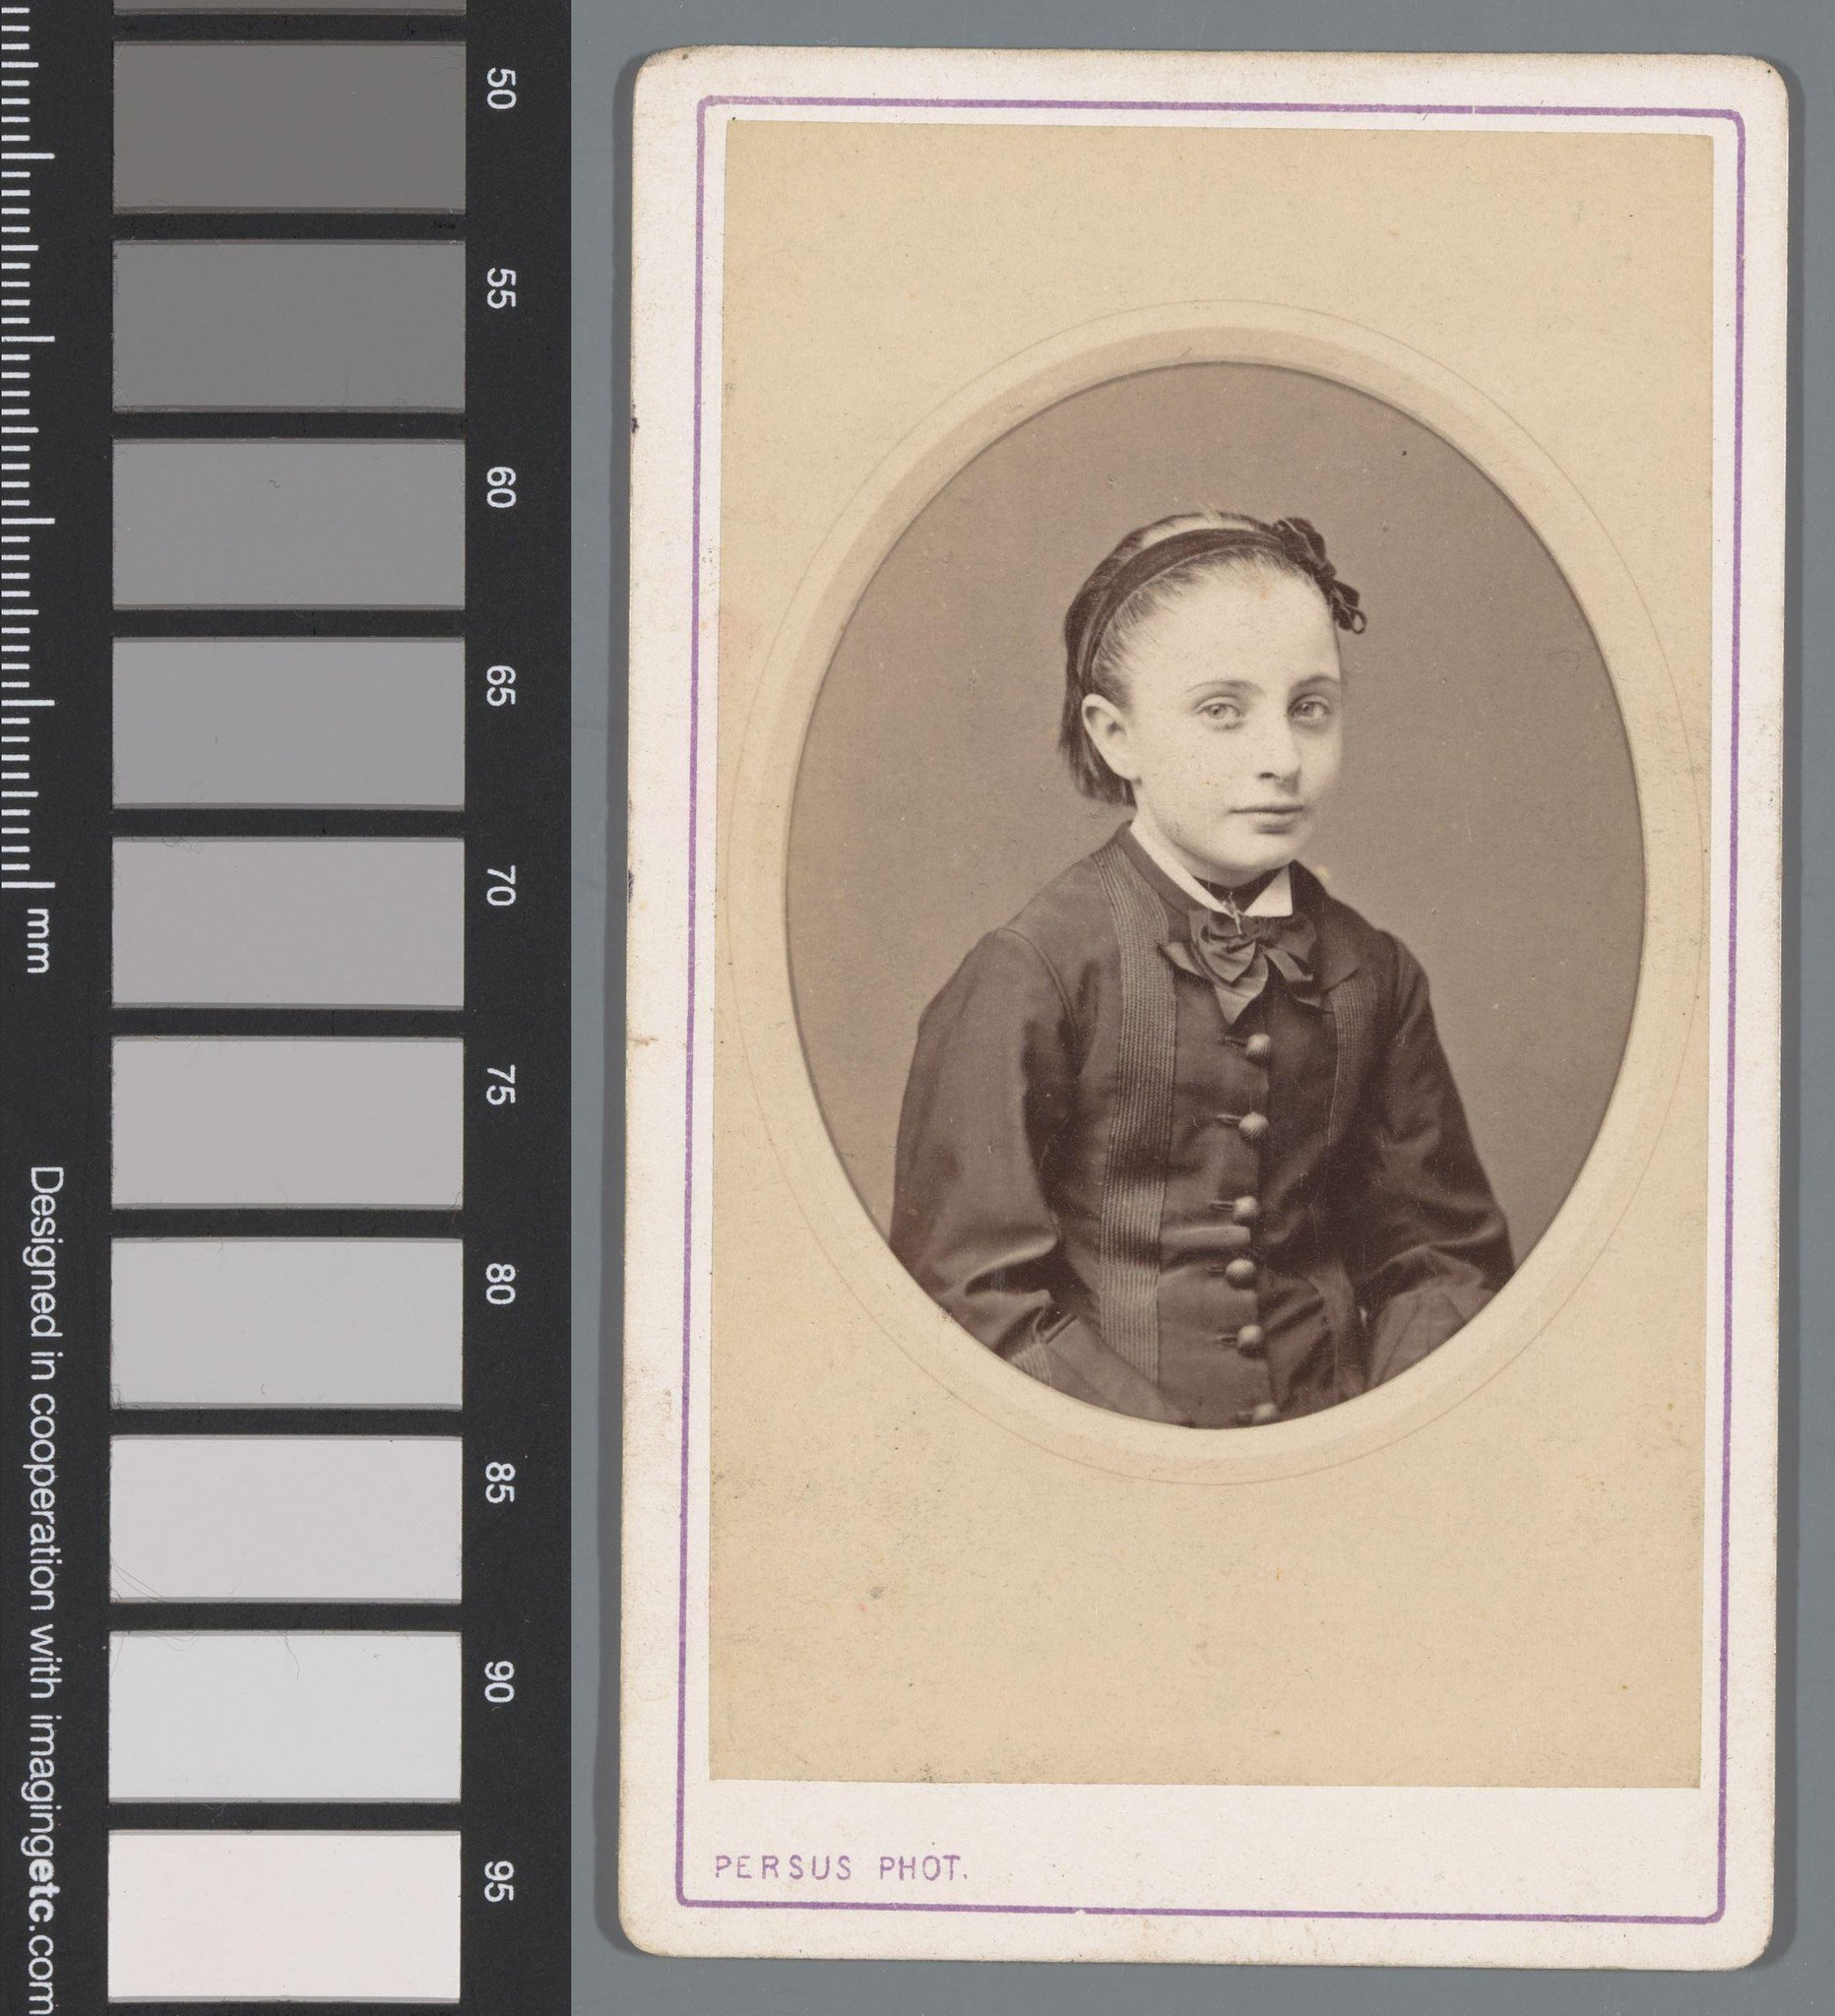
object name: carte de visite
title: Portret van een onbekend meisje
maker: nicolas claude persus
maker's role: fotograaf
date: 1875-1885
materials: cardboard, paper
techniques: albumen print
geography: paris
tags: girl (child between toddler and youth), anonymous historical person portrayed, paris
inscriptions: inscription: ‘Persus phot.’, inscription: ‘Persus/ Photographe/ 76, Ru ede Rennes, 76/ Ancien N. 8 de la rue Cassette/ Paris/ Tous les Clichés sont conservés.’